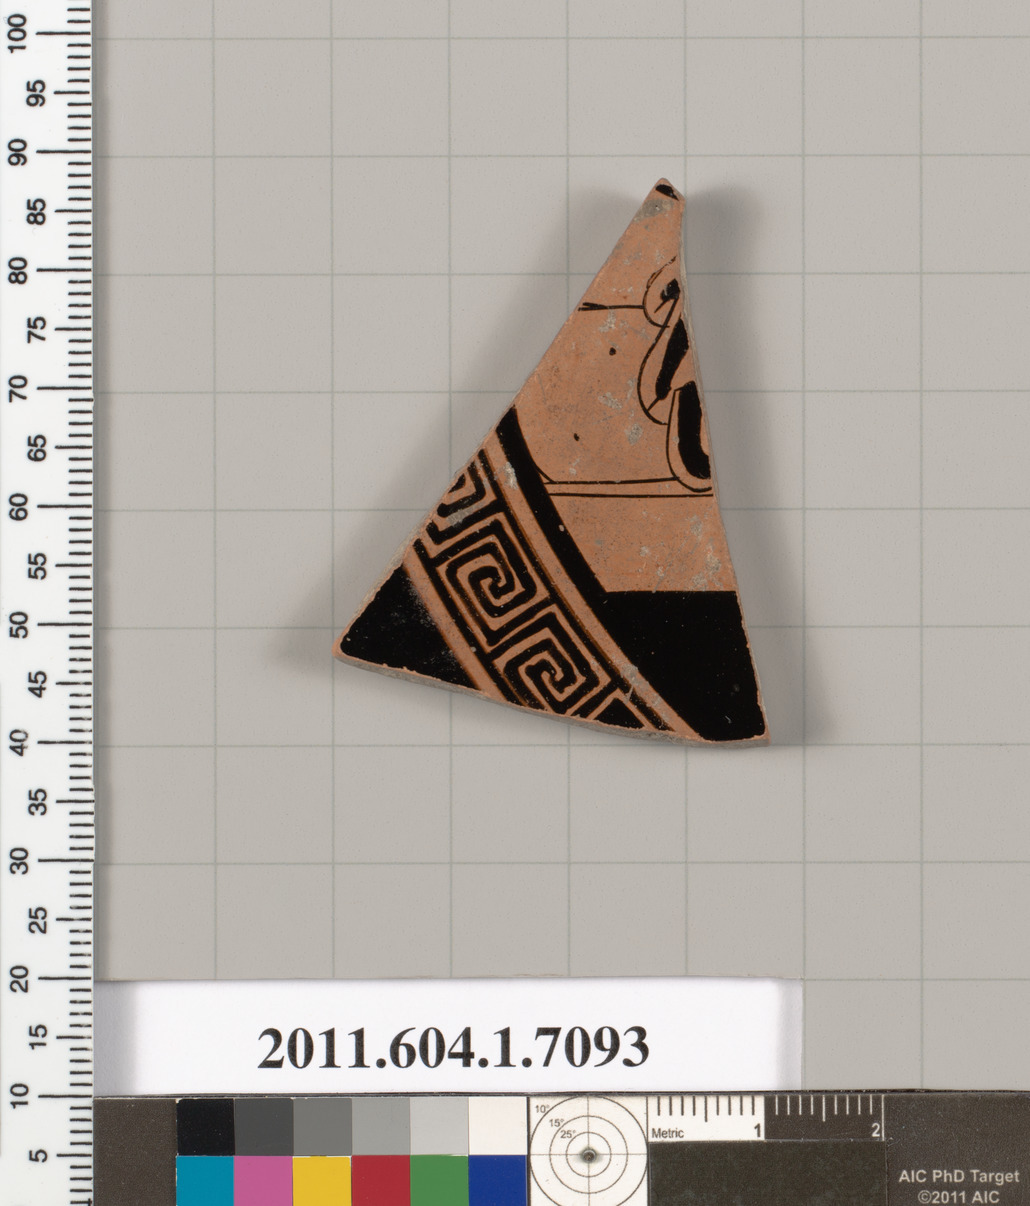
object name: kylix fragment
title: Terracotta fragment of a kylix (drinking cup)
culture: greek, attic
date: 500-480 BCE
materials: terracotta